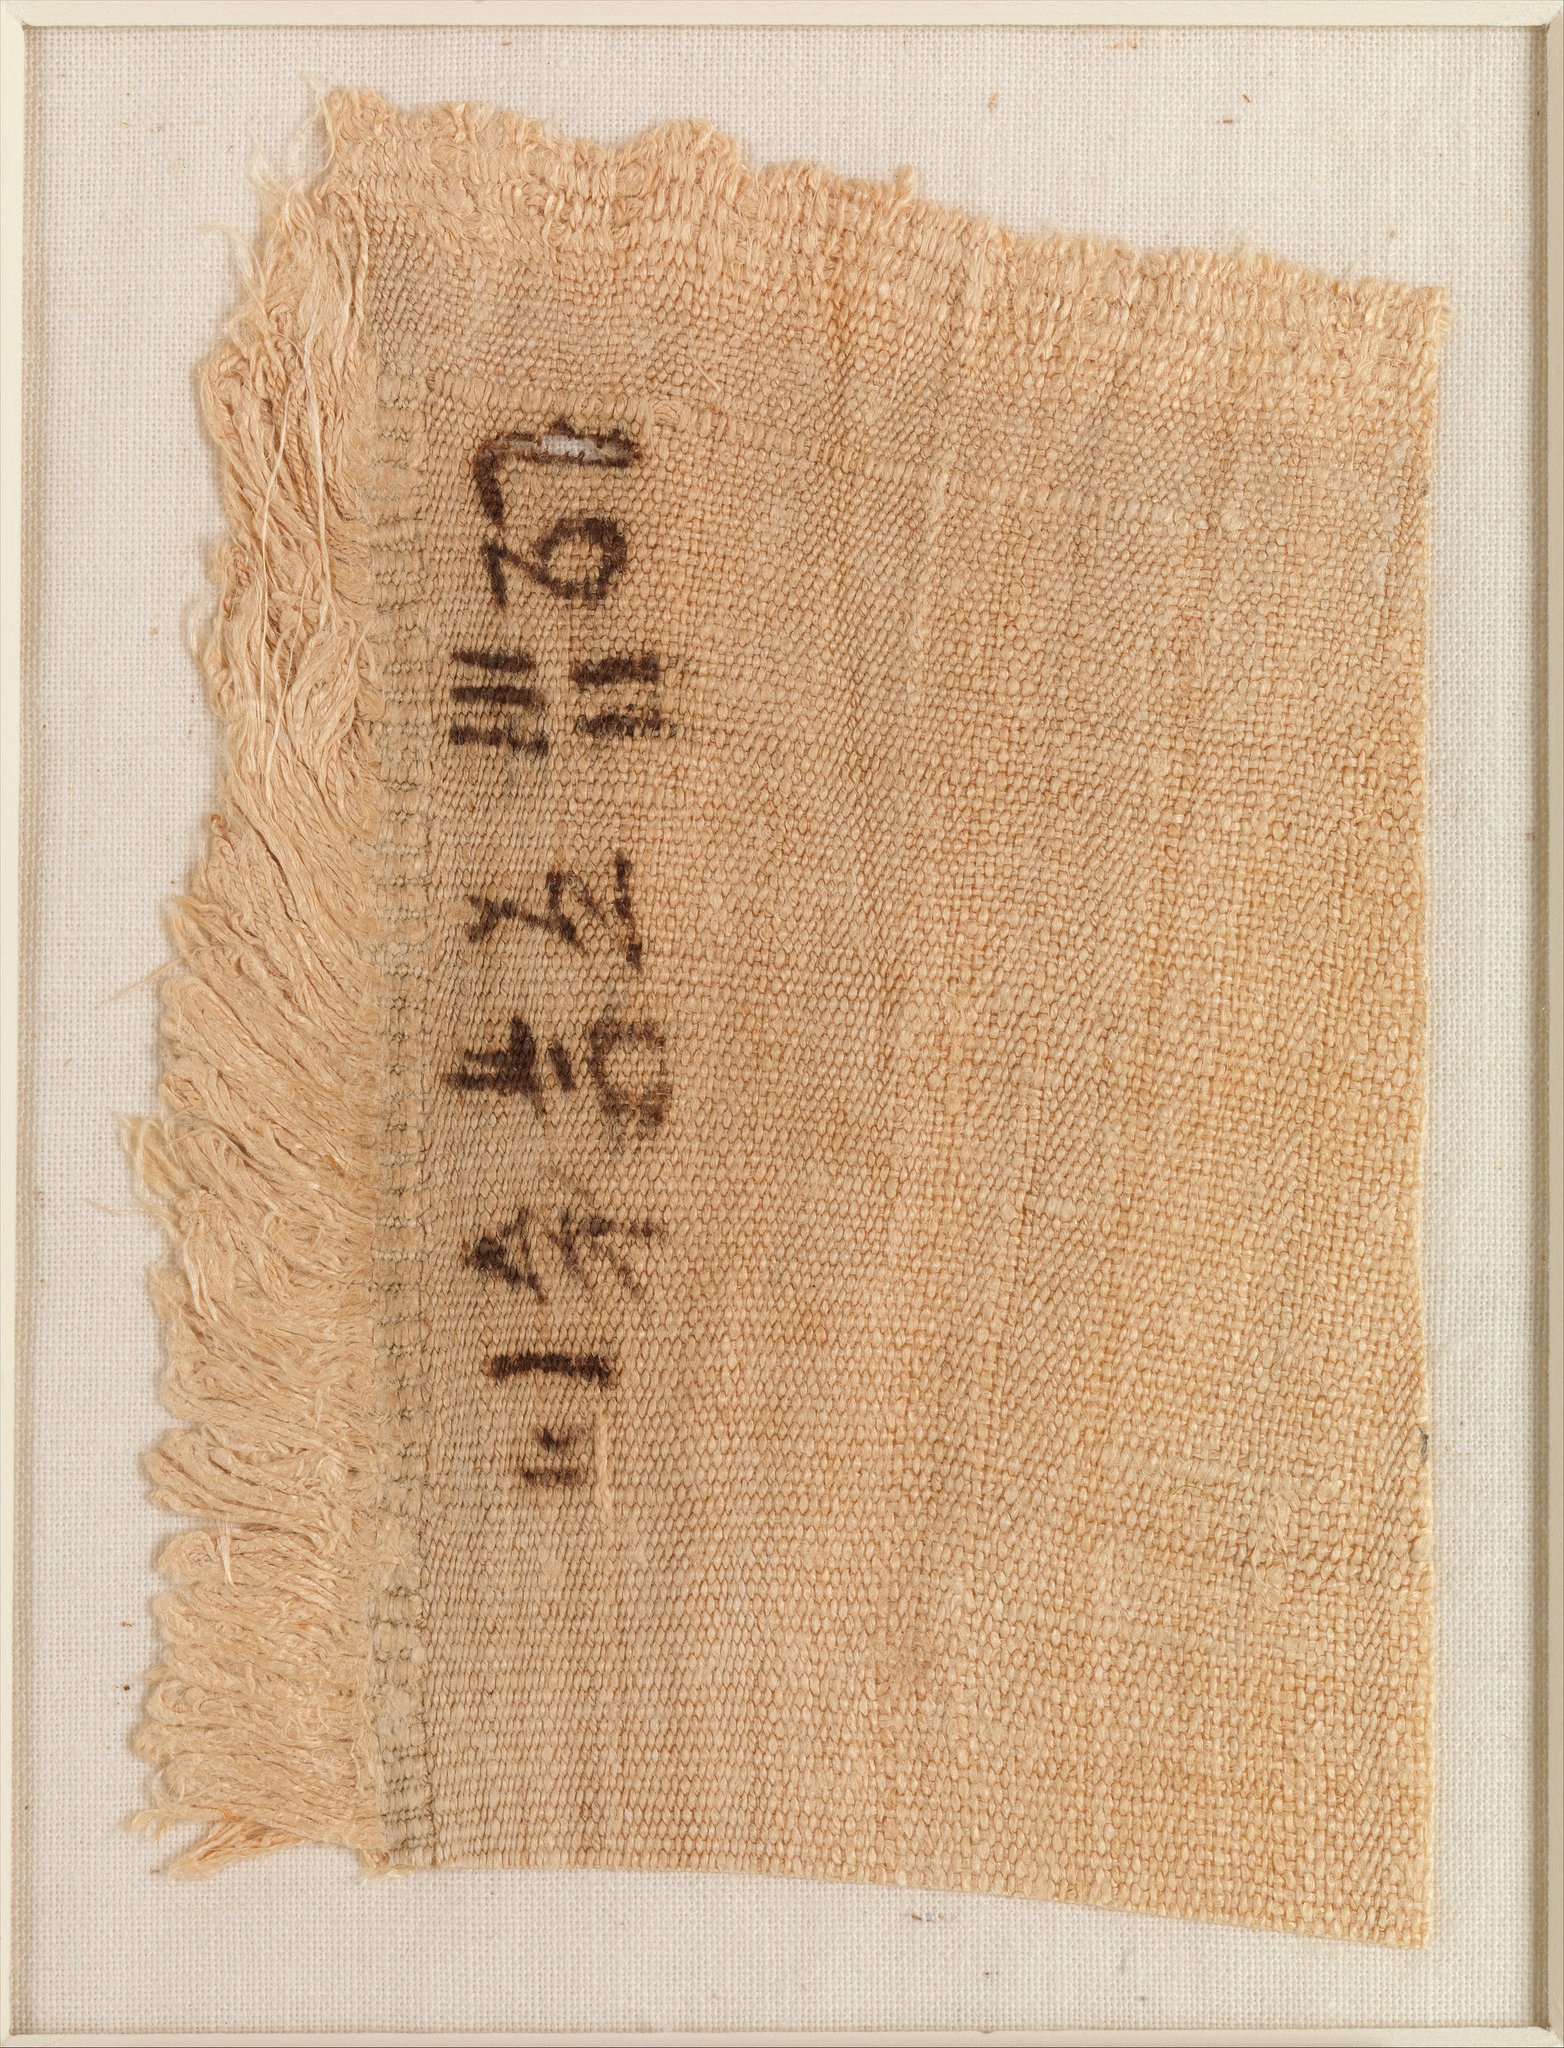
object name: linen mark, wah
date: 1981-1975 BCE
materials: linen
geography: egypt